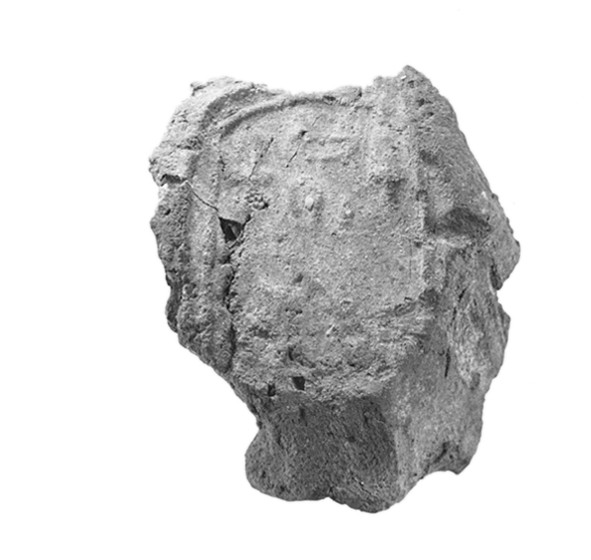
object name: sealing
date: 2030-1640 BCE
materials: clay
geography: egypt